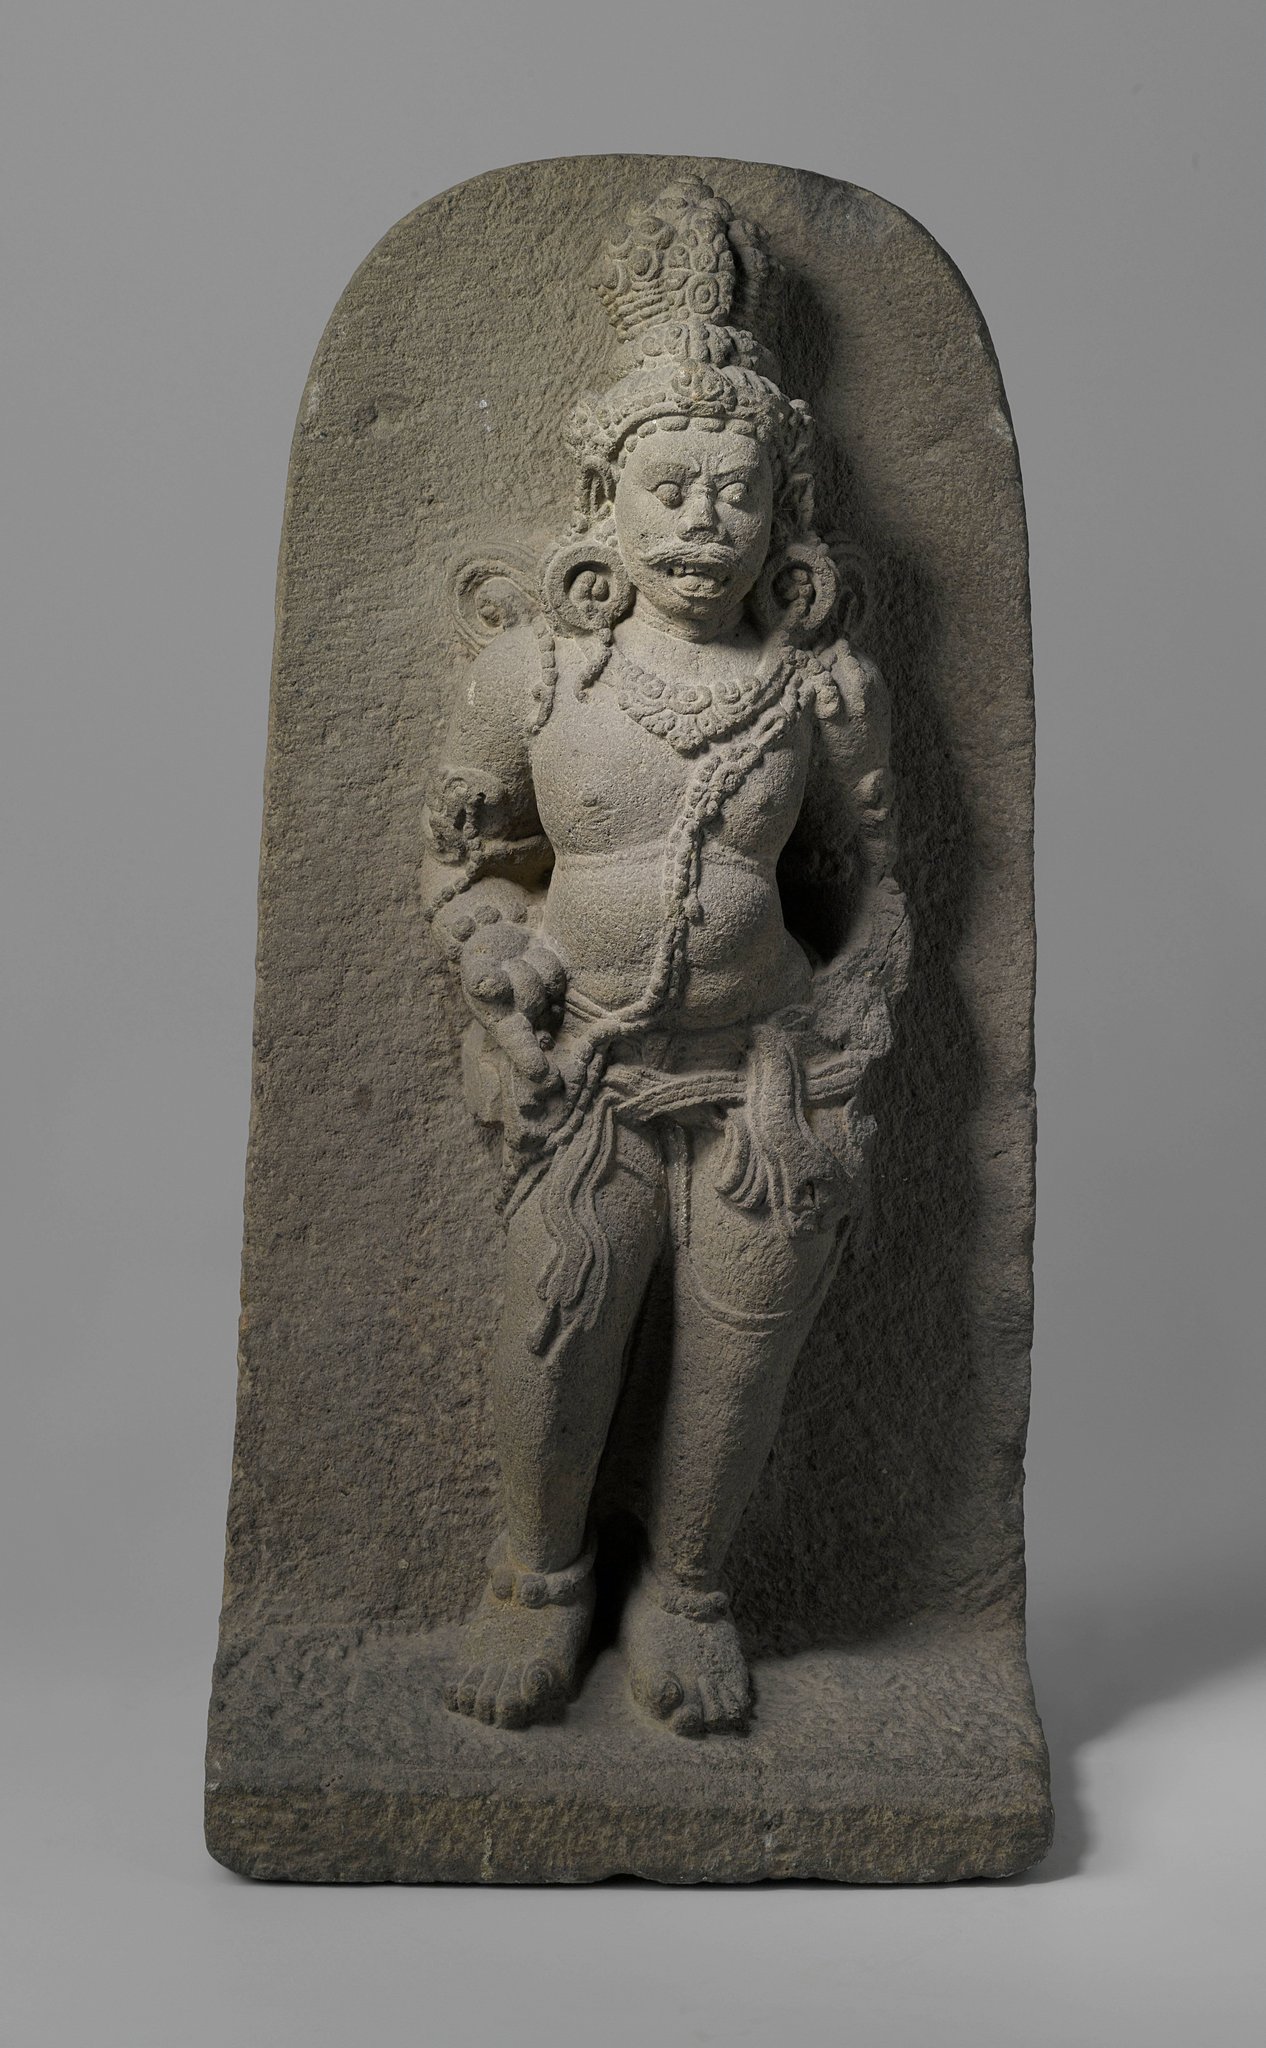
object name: figure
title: Mahakala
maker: Anonymous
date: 800-900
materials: stone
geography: central java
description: The second guard at a Shiva temple is Mahakala, who stands on Shiva’s left side. His demonic characteristics – wild hair, bulging eyes and open mouth, a fat body and curled-up toes – make him the opposite of the graceful Nandishvara. It is likely that his left hand once rested on a club. His index finger points downwards, towards worshippers entering the temple.